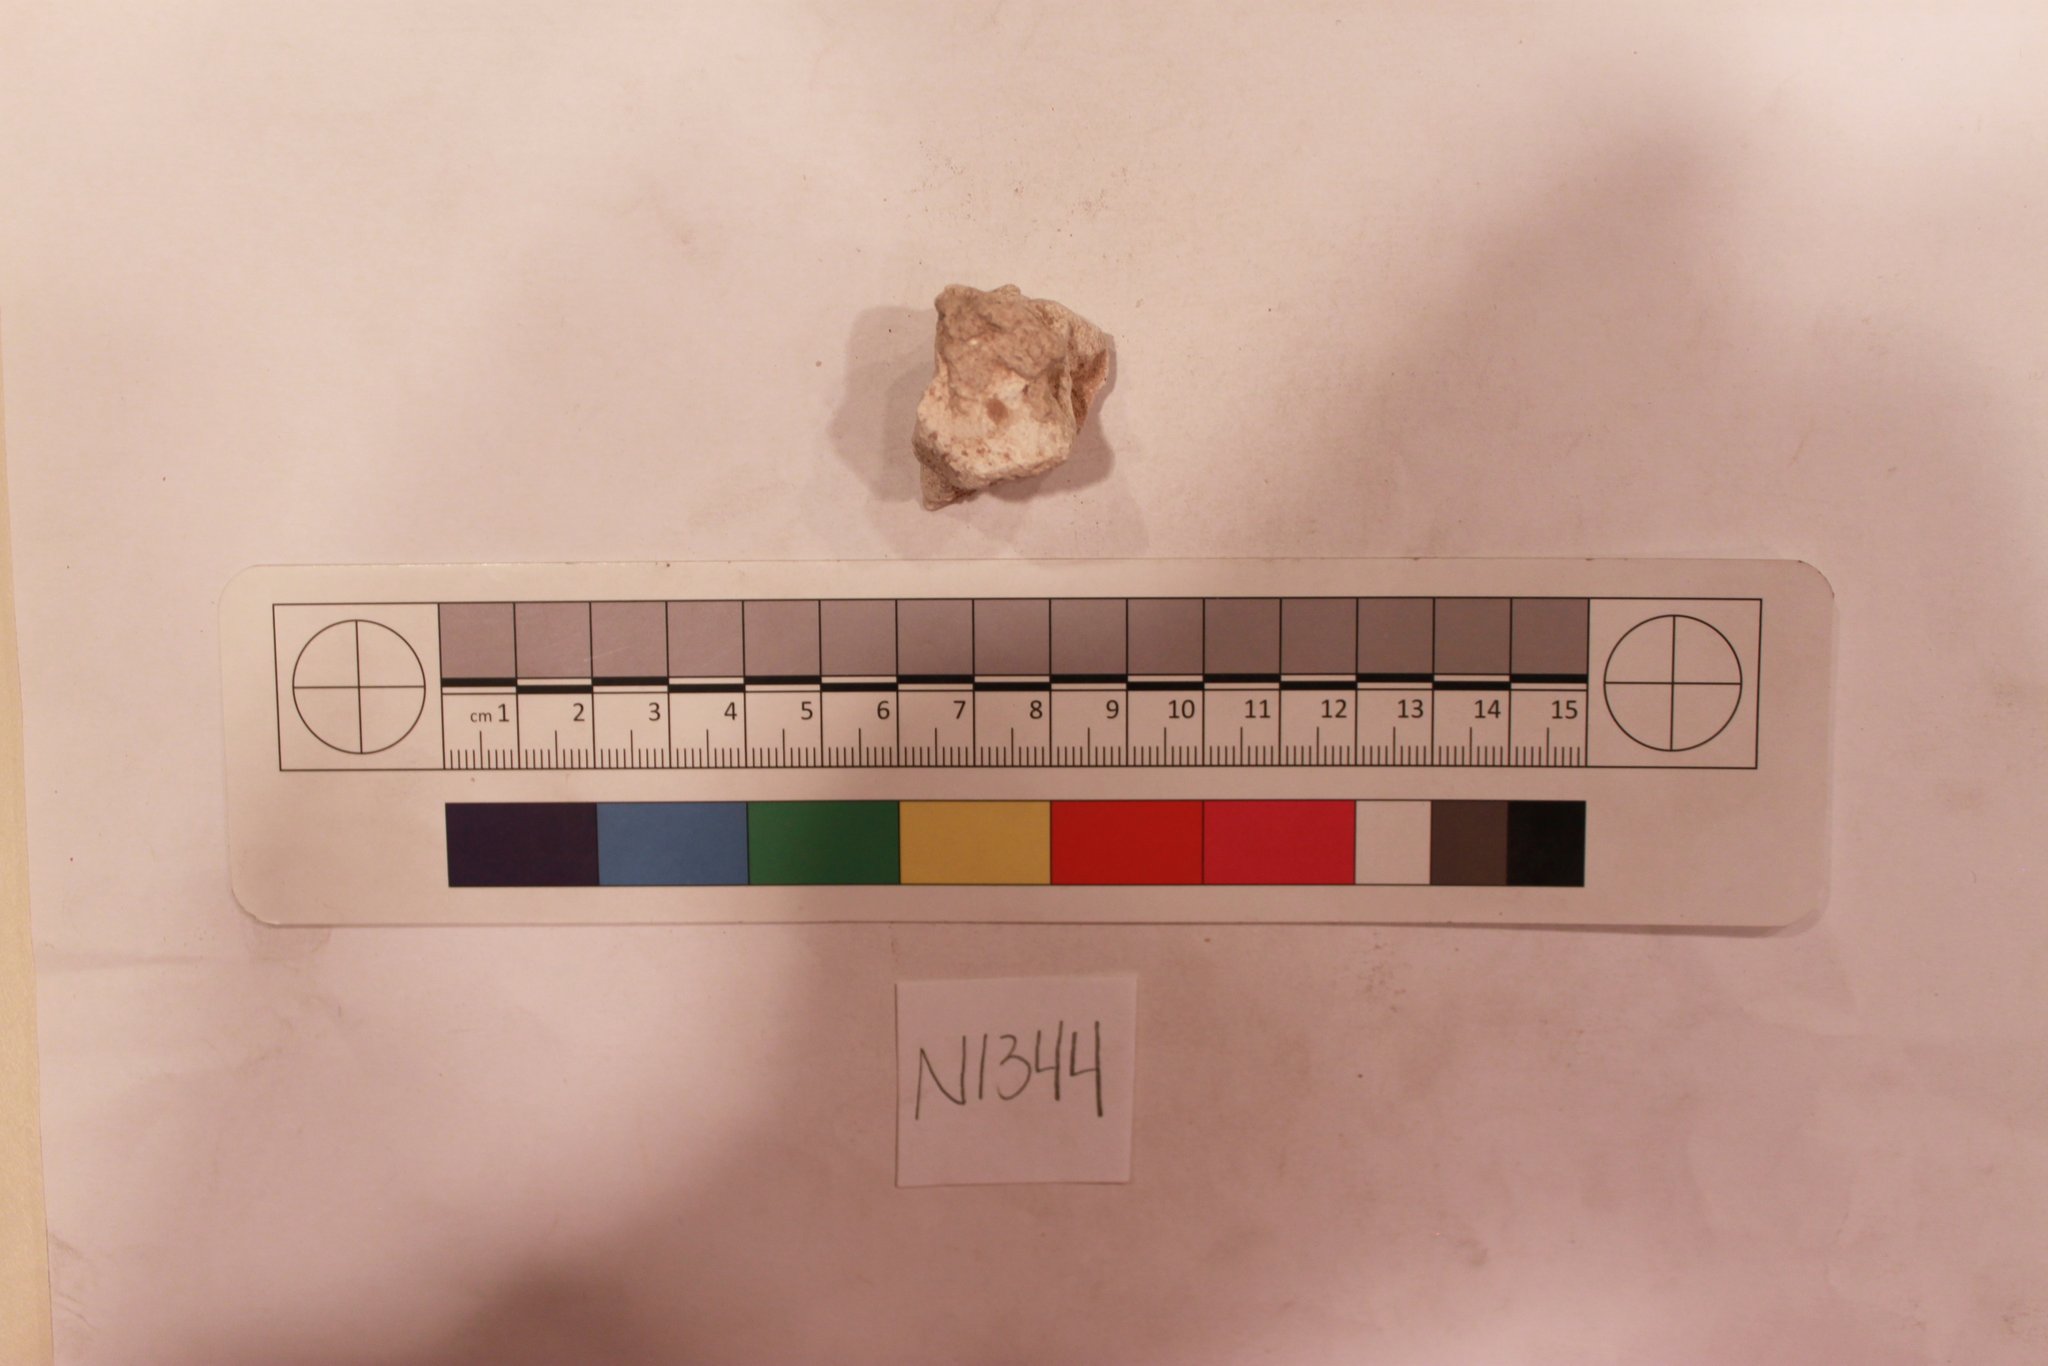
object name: fragment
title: Stucco Fragment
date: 701-1200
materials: plaster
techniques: carving, painting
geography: iran